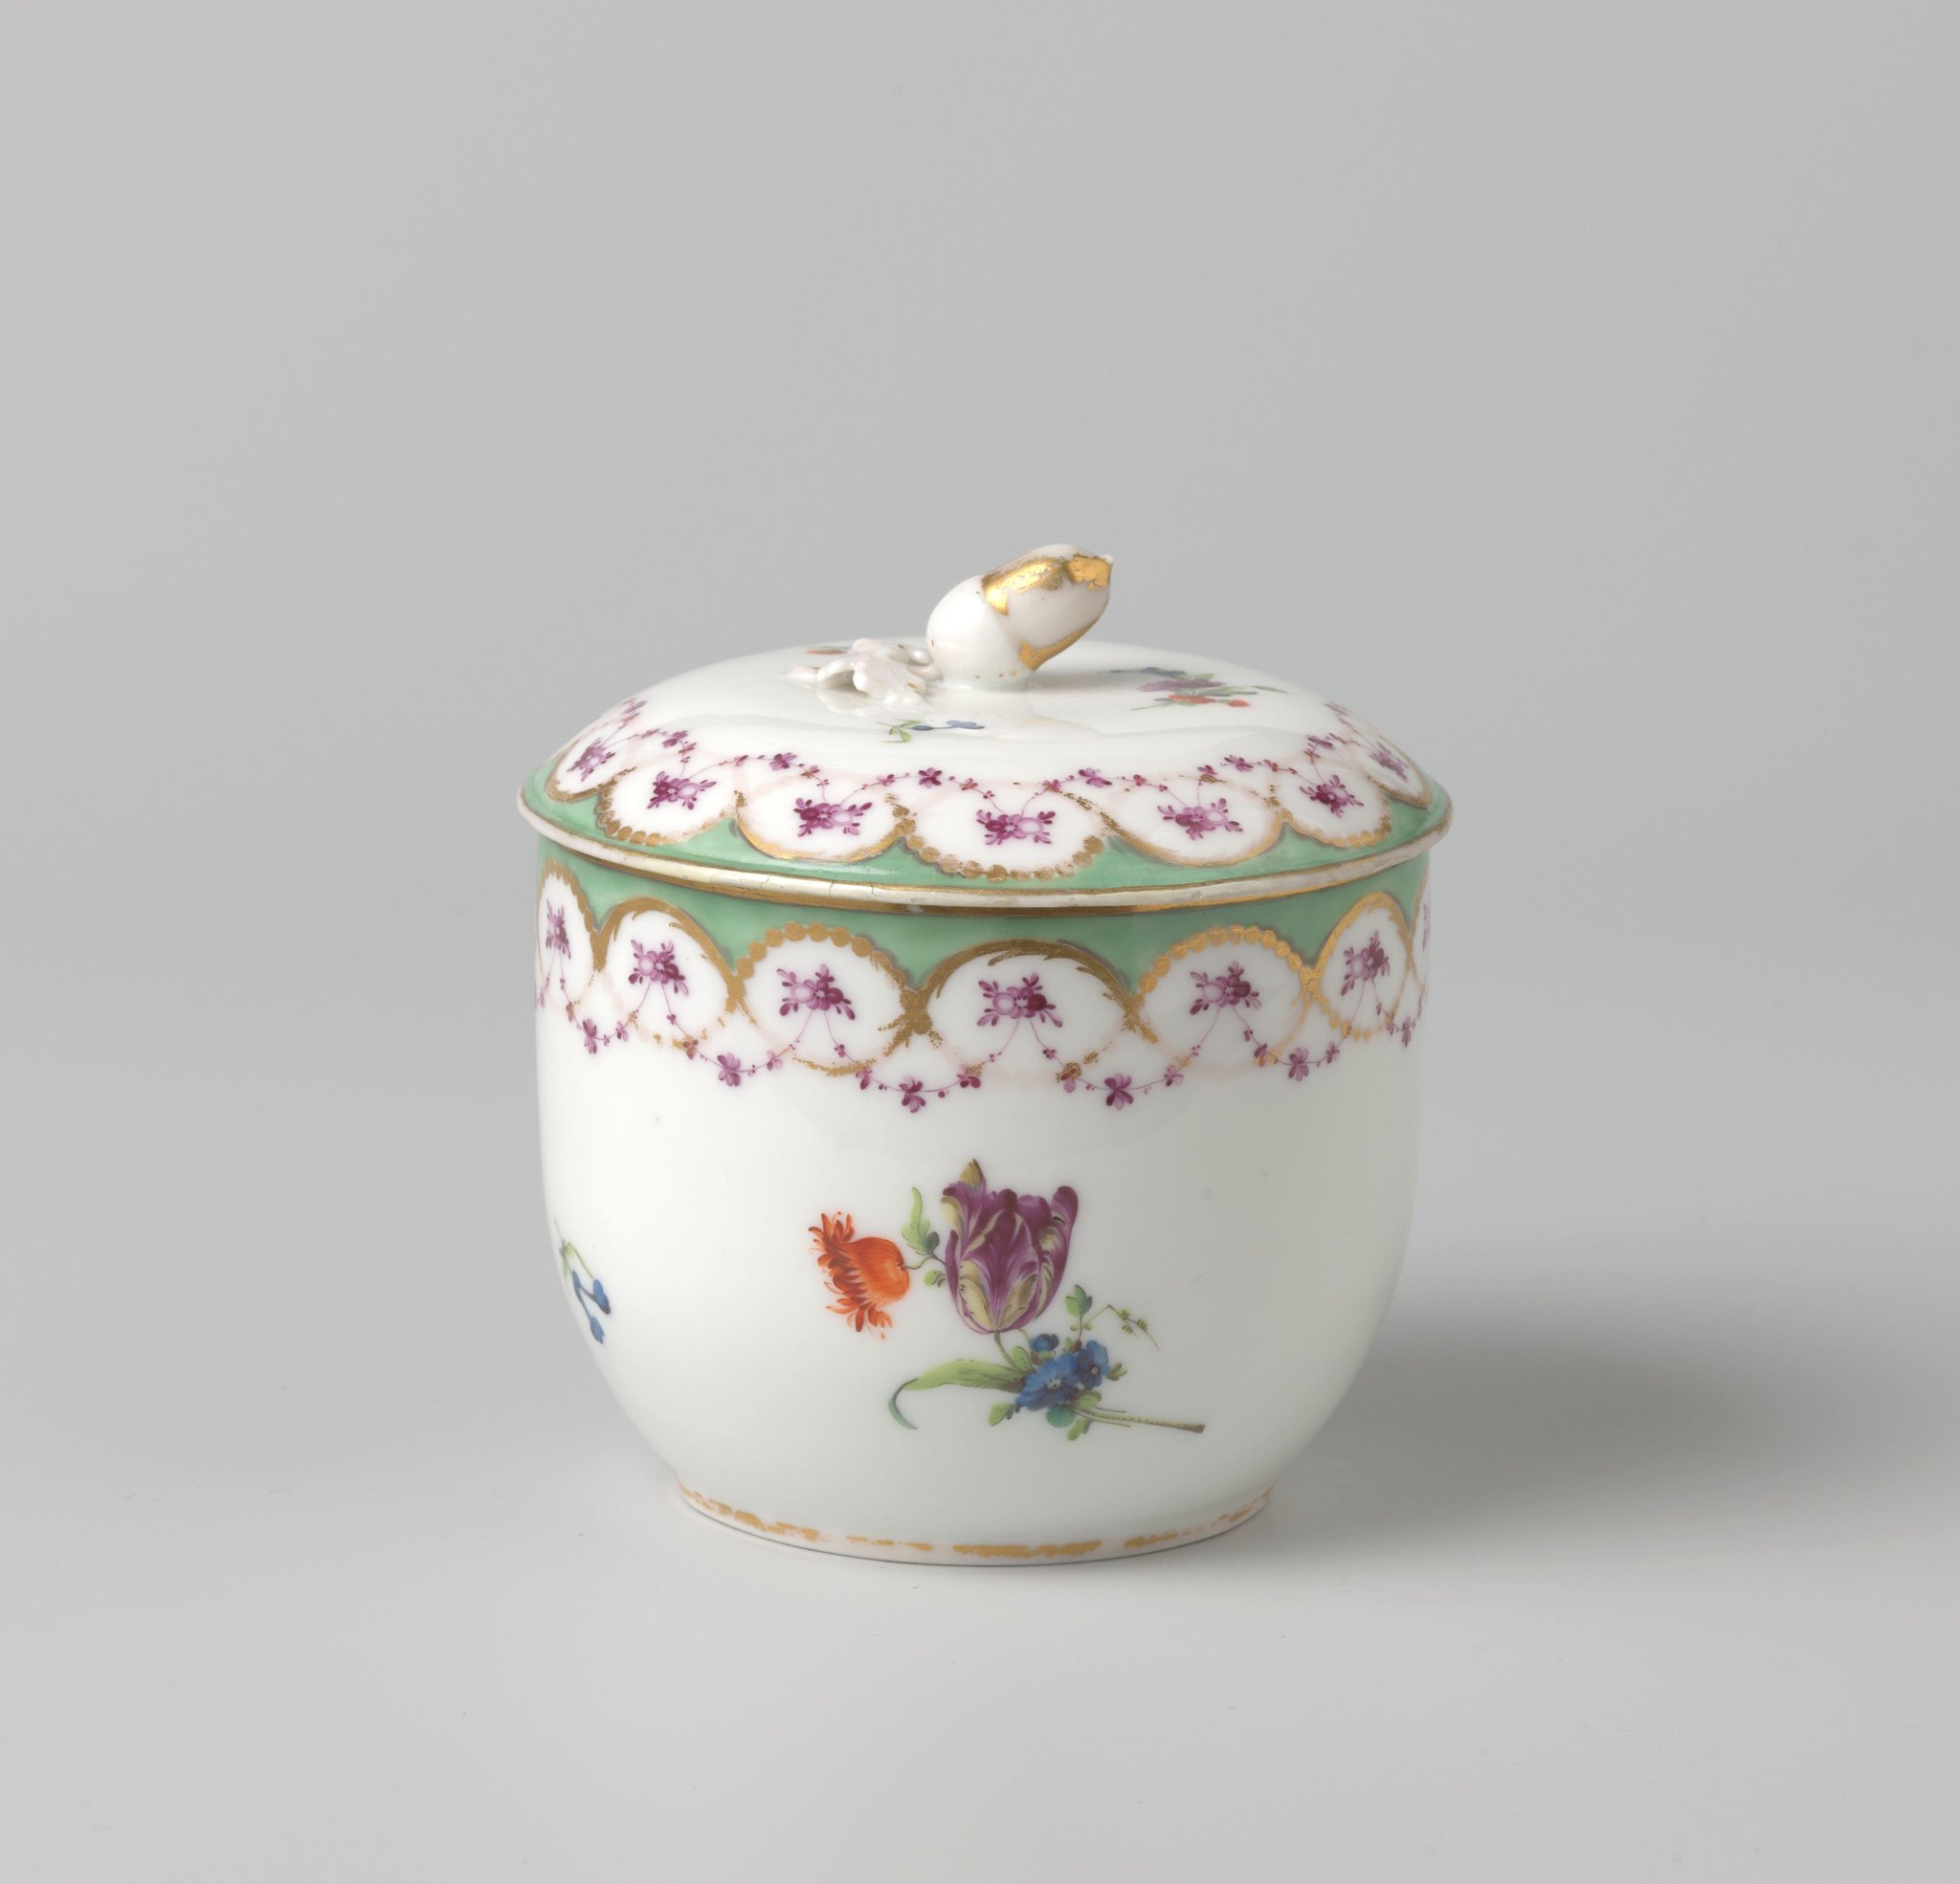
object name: tea service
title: Suikerpot van theeservies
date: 1784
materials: porcelain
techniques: painted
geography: loosdrecht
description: Suikerpot van theeservies. De versiering bestaat uit strooibloemen op het plat en langs de rand een geornamenteerde band. Gemerkt Amstel.